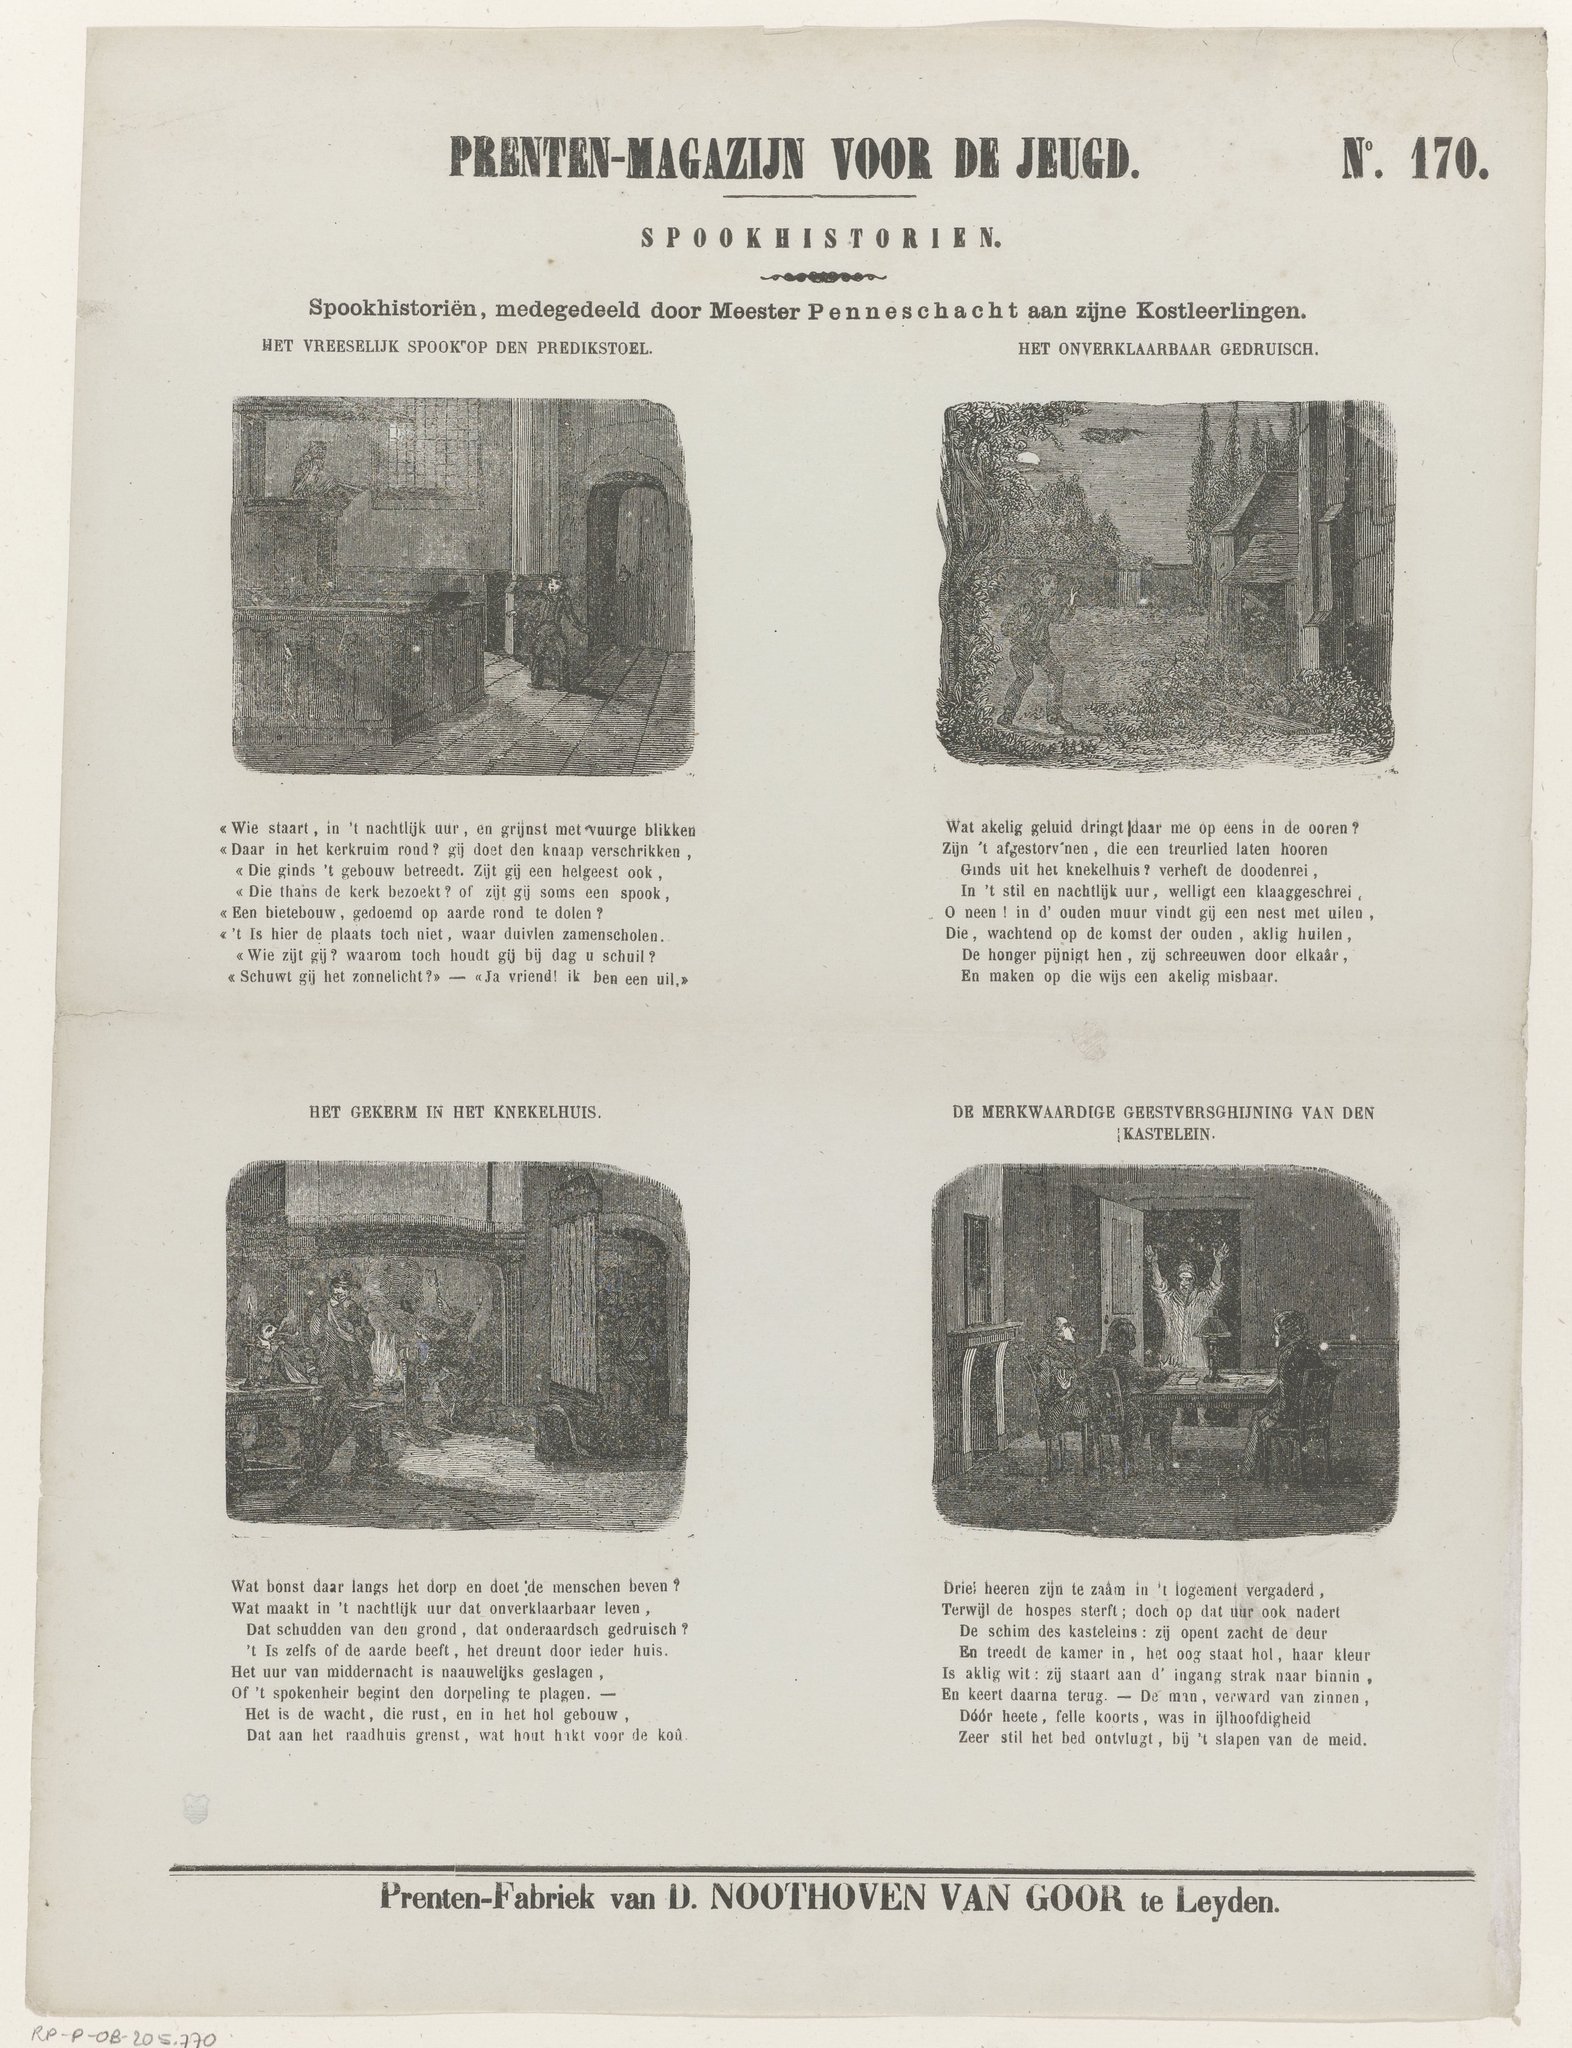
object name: popular print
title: Spookhistoriën, medegedeeld door Meester Penneschacht aan zijne kostleerlingen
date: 1850-1881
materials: paper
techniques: letterpress printing, engraving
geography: leiden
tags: tales and fairy tales, spirit, ghost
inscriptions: collector's mark: Lugt 2760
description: Blad met 4 scènes uit een spookverhaal. Boven elke voorstelling een titel en onder elke voorstelling een achtregelig vers. Genummerd rechtsboven: No. 170.